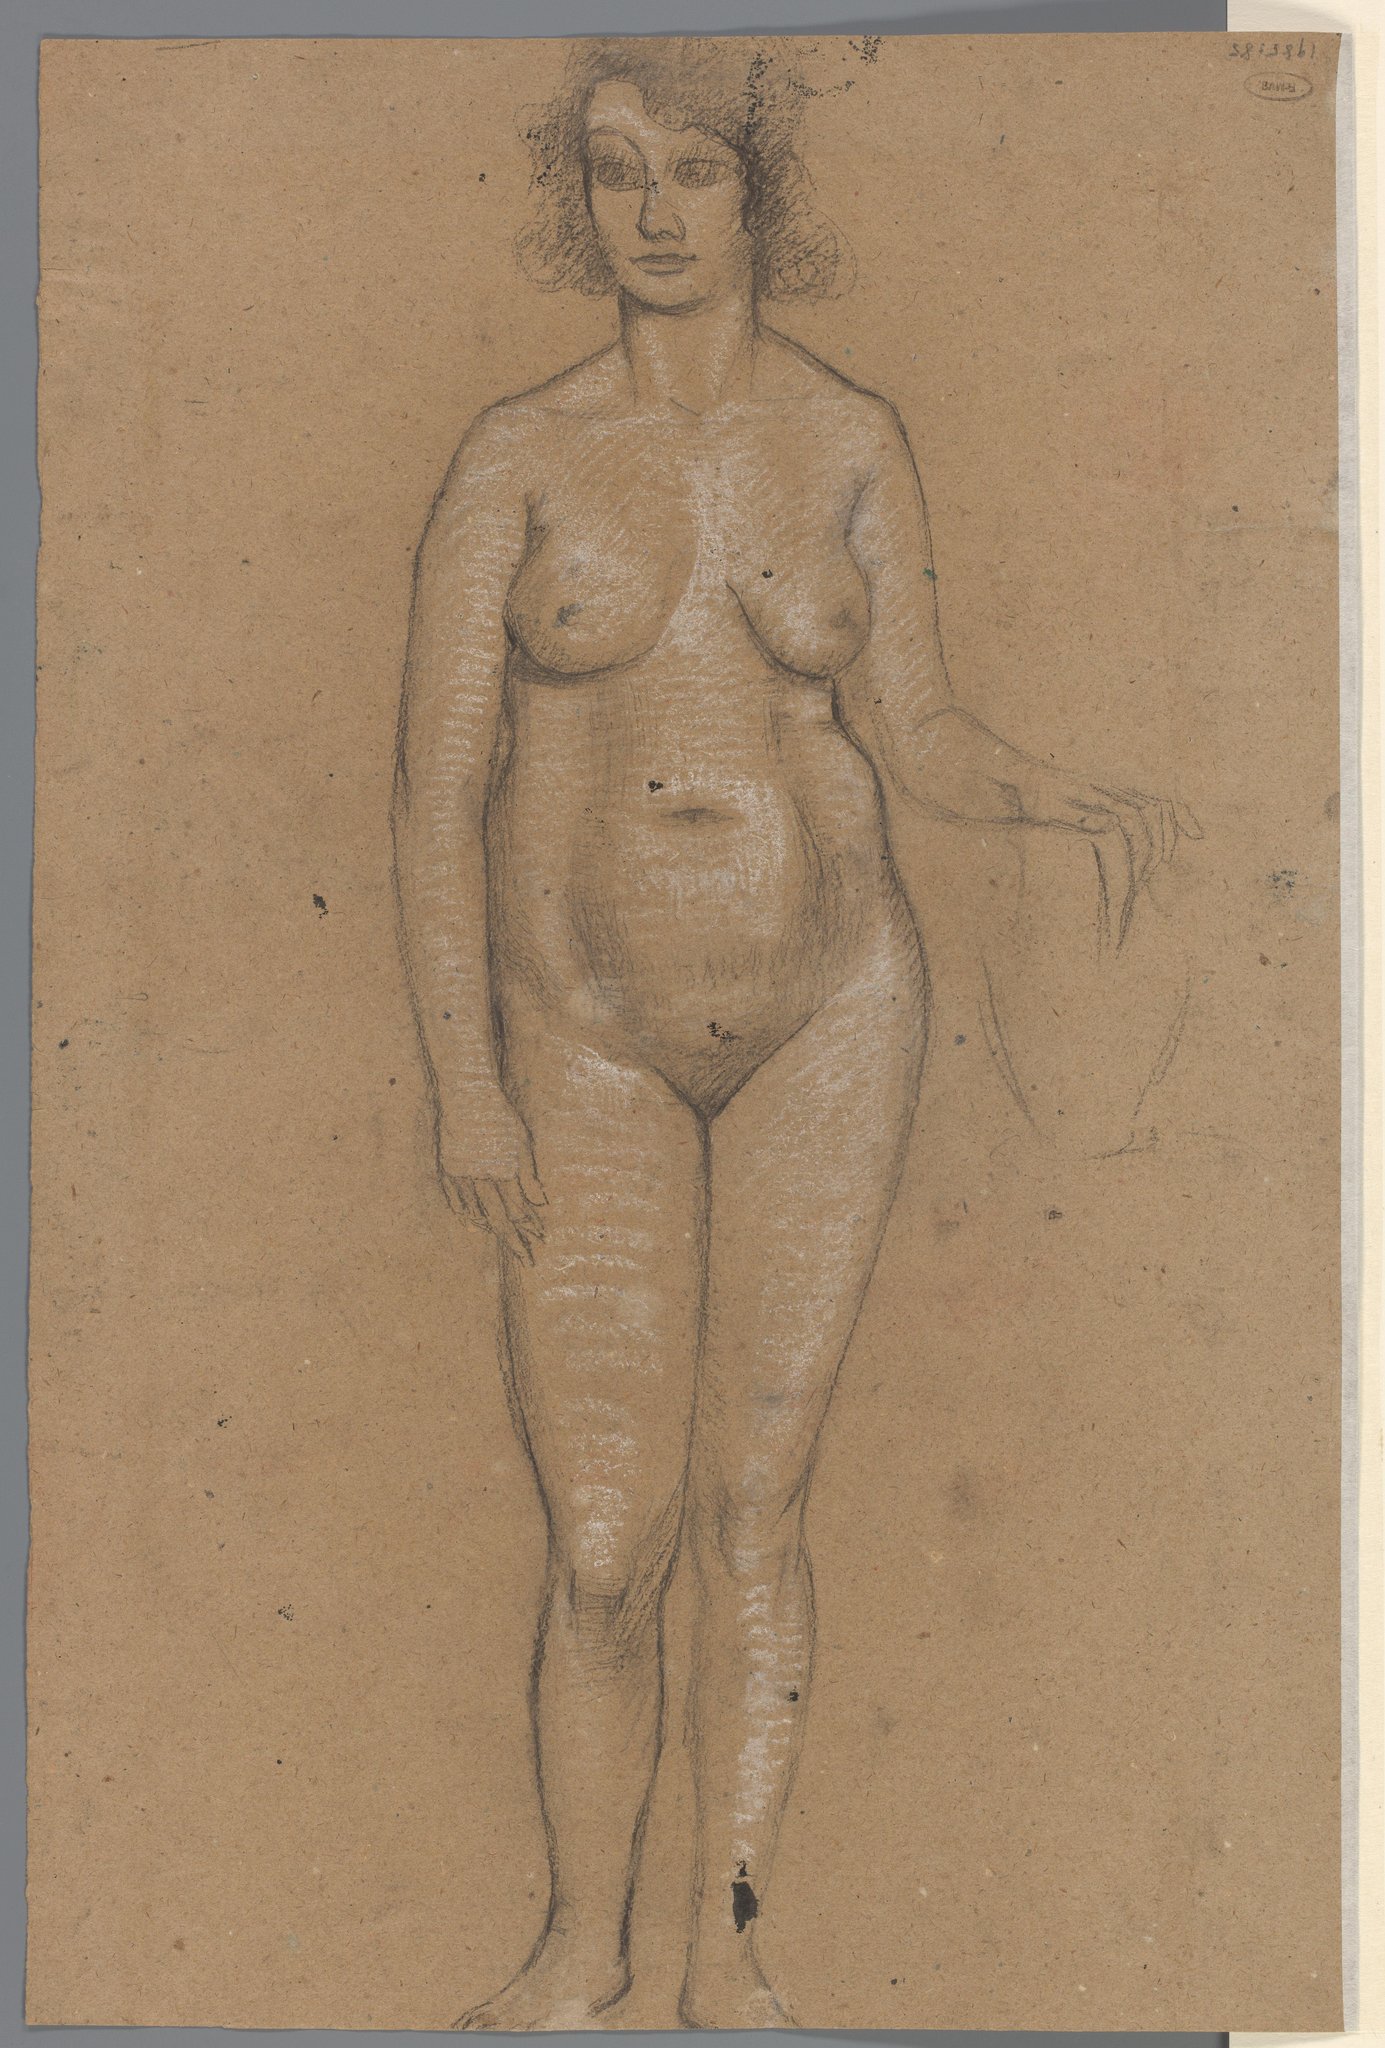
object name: drawing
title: Staande naakte vrouw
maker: roelf gerbrands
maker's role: designer, draughtsman, print maker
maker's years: 1891-1954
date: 1901-1954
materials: chalk, paper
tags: woman (showing herself) undressed, quasi-nude, standing figure - aa - female human figure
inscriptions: collector's mark: Lugt 2228